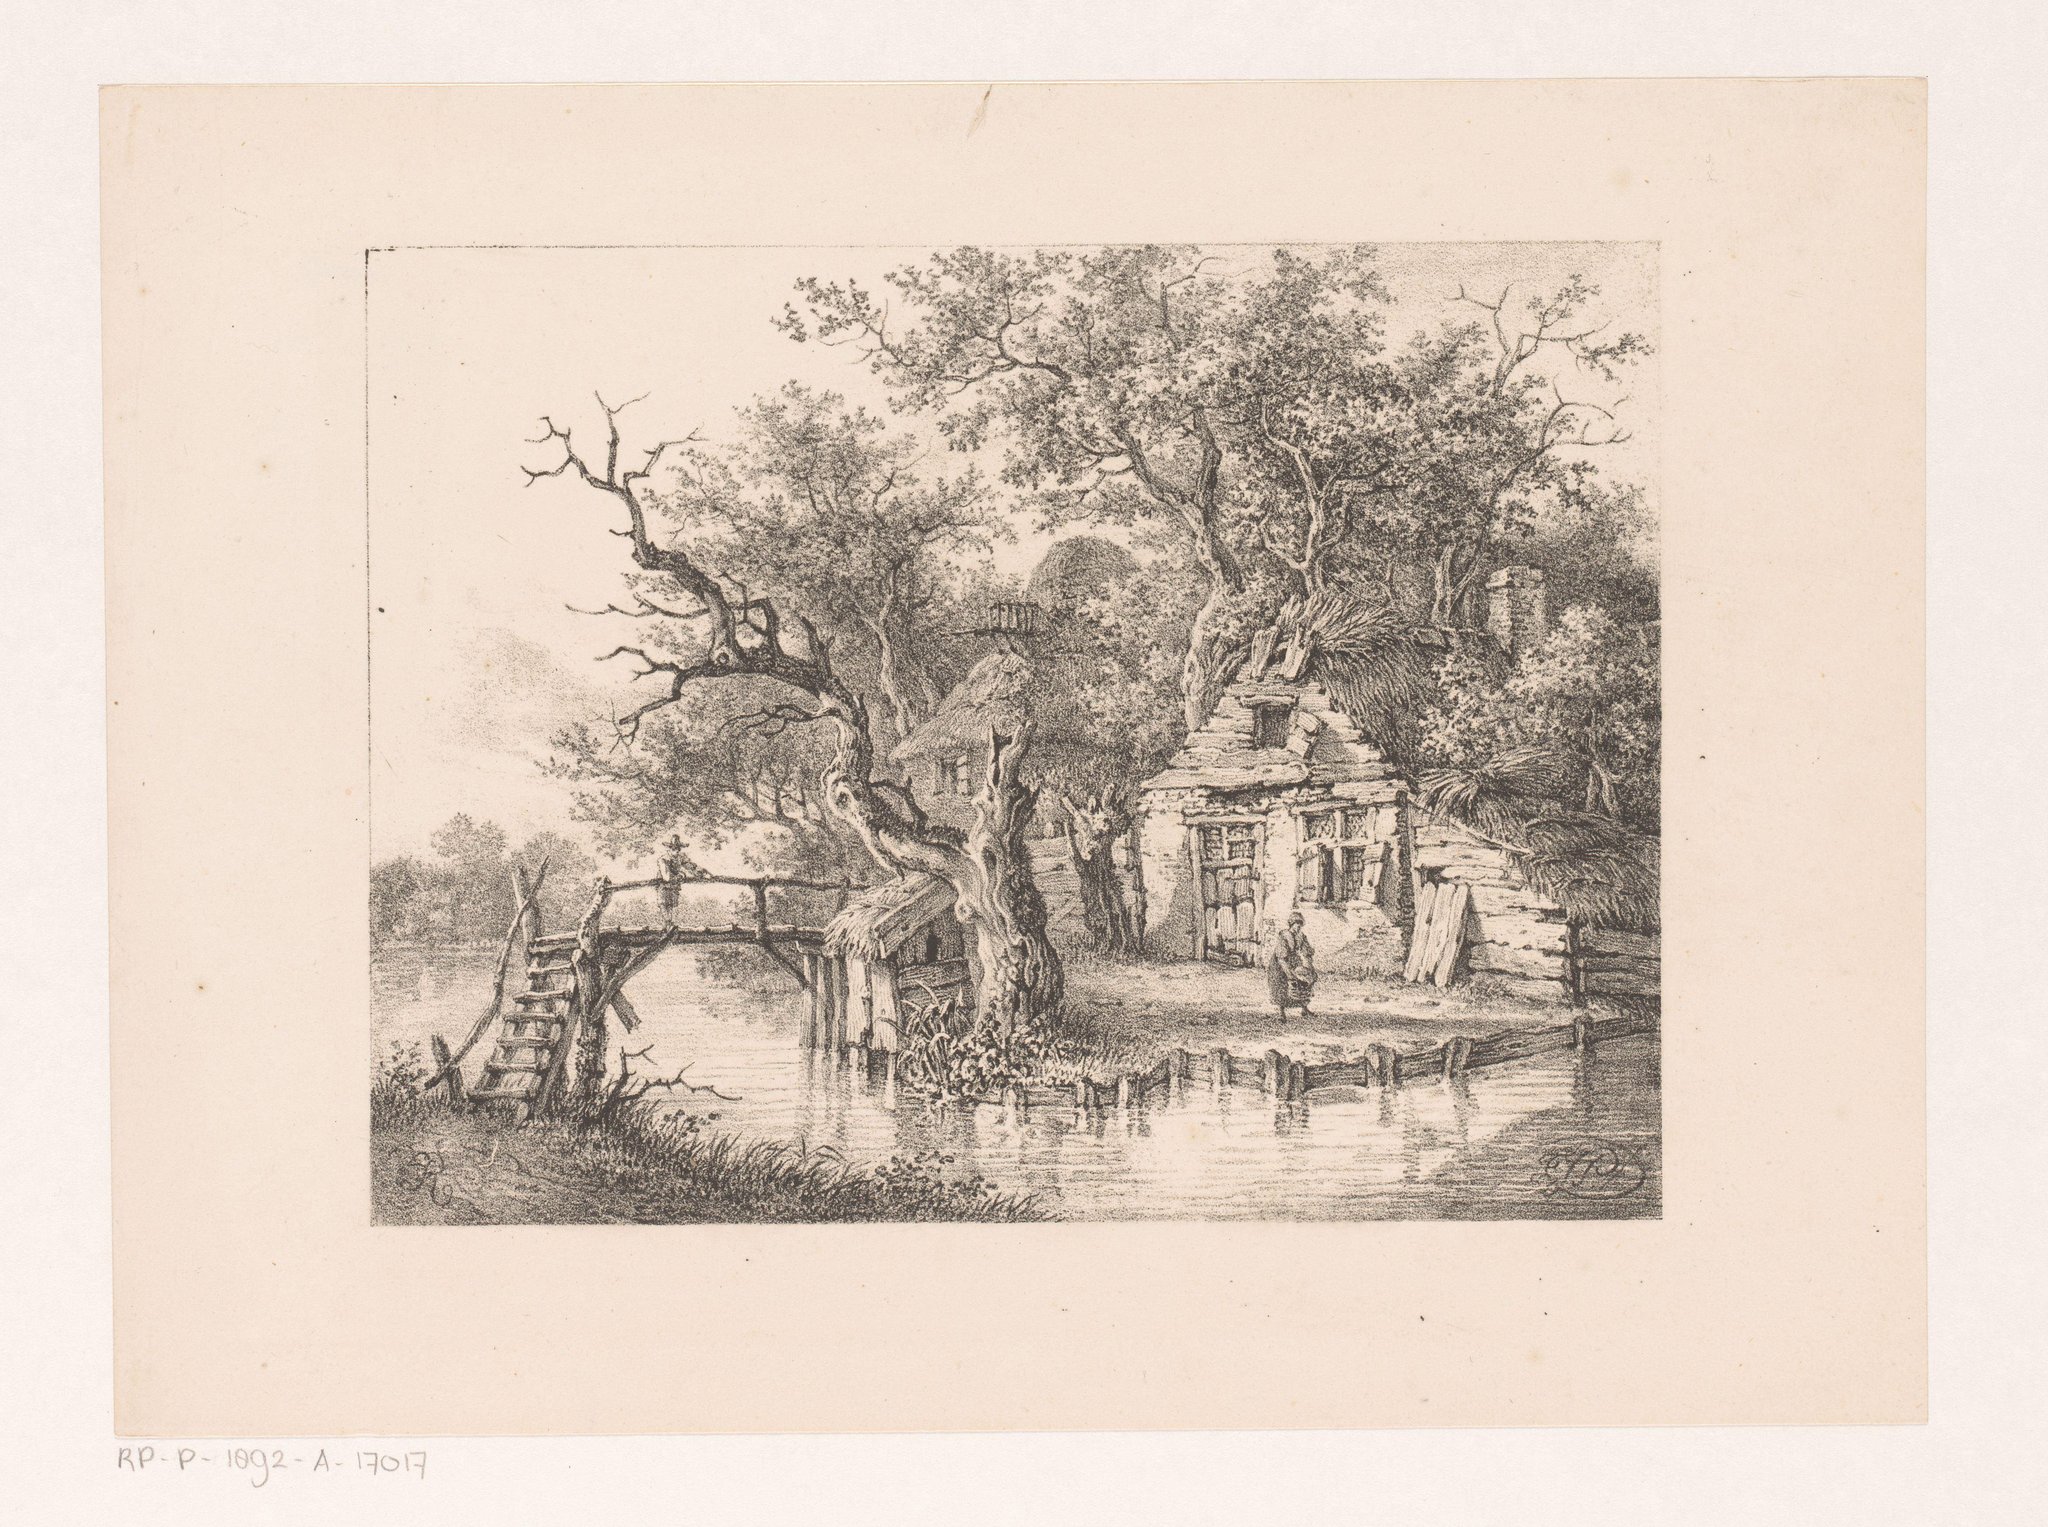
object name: print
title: Boerderij aan het water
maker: françois joseph pfeiffer (ii)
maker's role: draughtsman, print maker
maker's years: 1778-1835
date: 1809-1835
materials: paper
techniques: lithograph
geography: amsterdam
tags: landscapes, farm or solitary house in landscape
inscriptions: collector's mark: Lugt 2228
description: Voor een boerderij aan het water staat een vrouw met een mand. Op een brug boven het water staat een man.